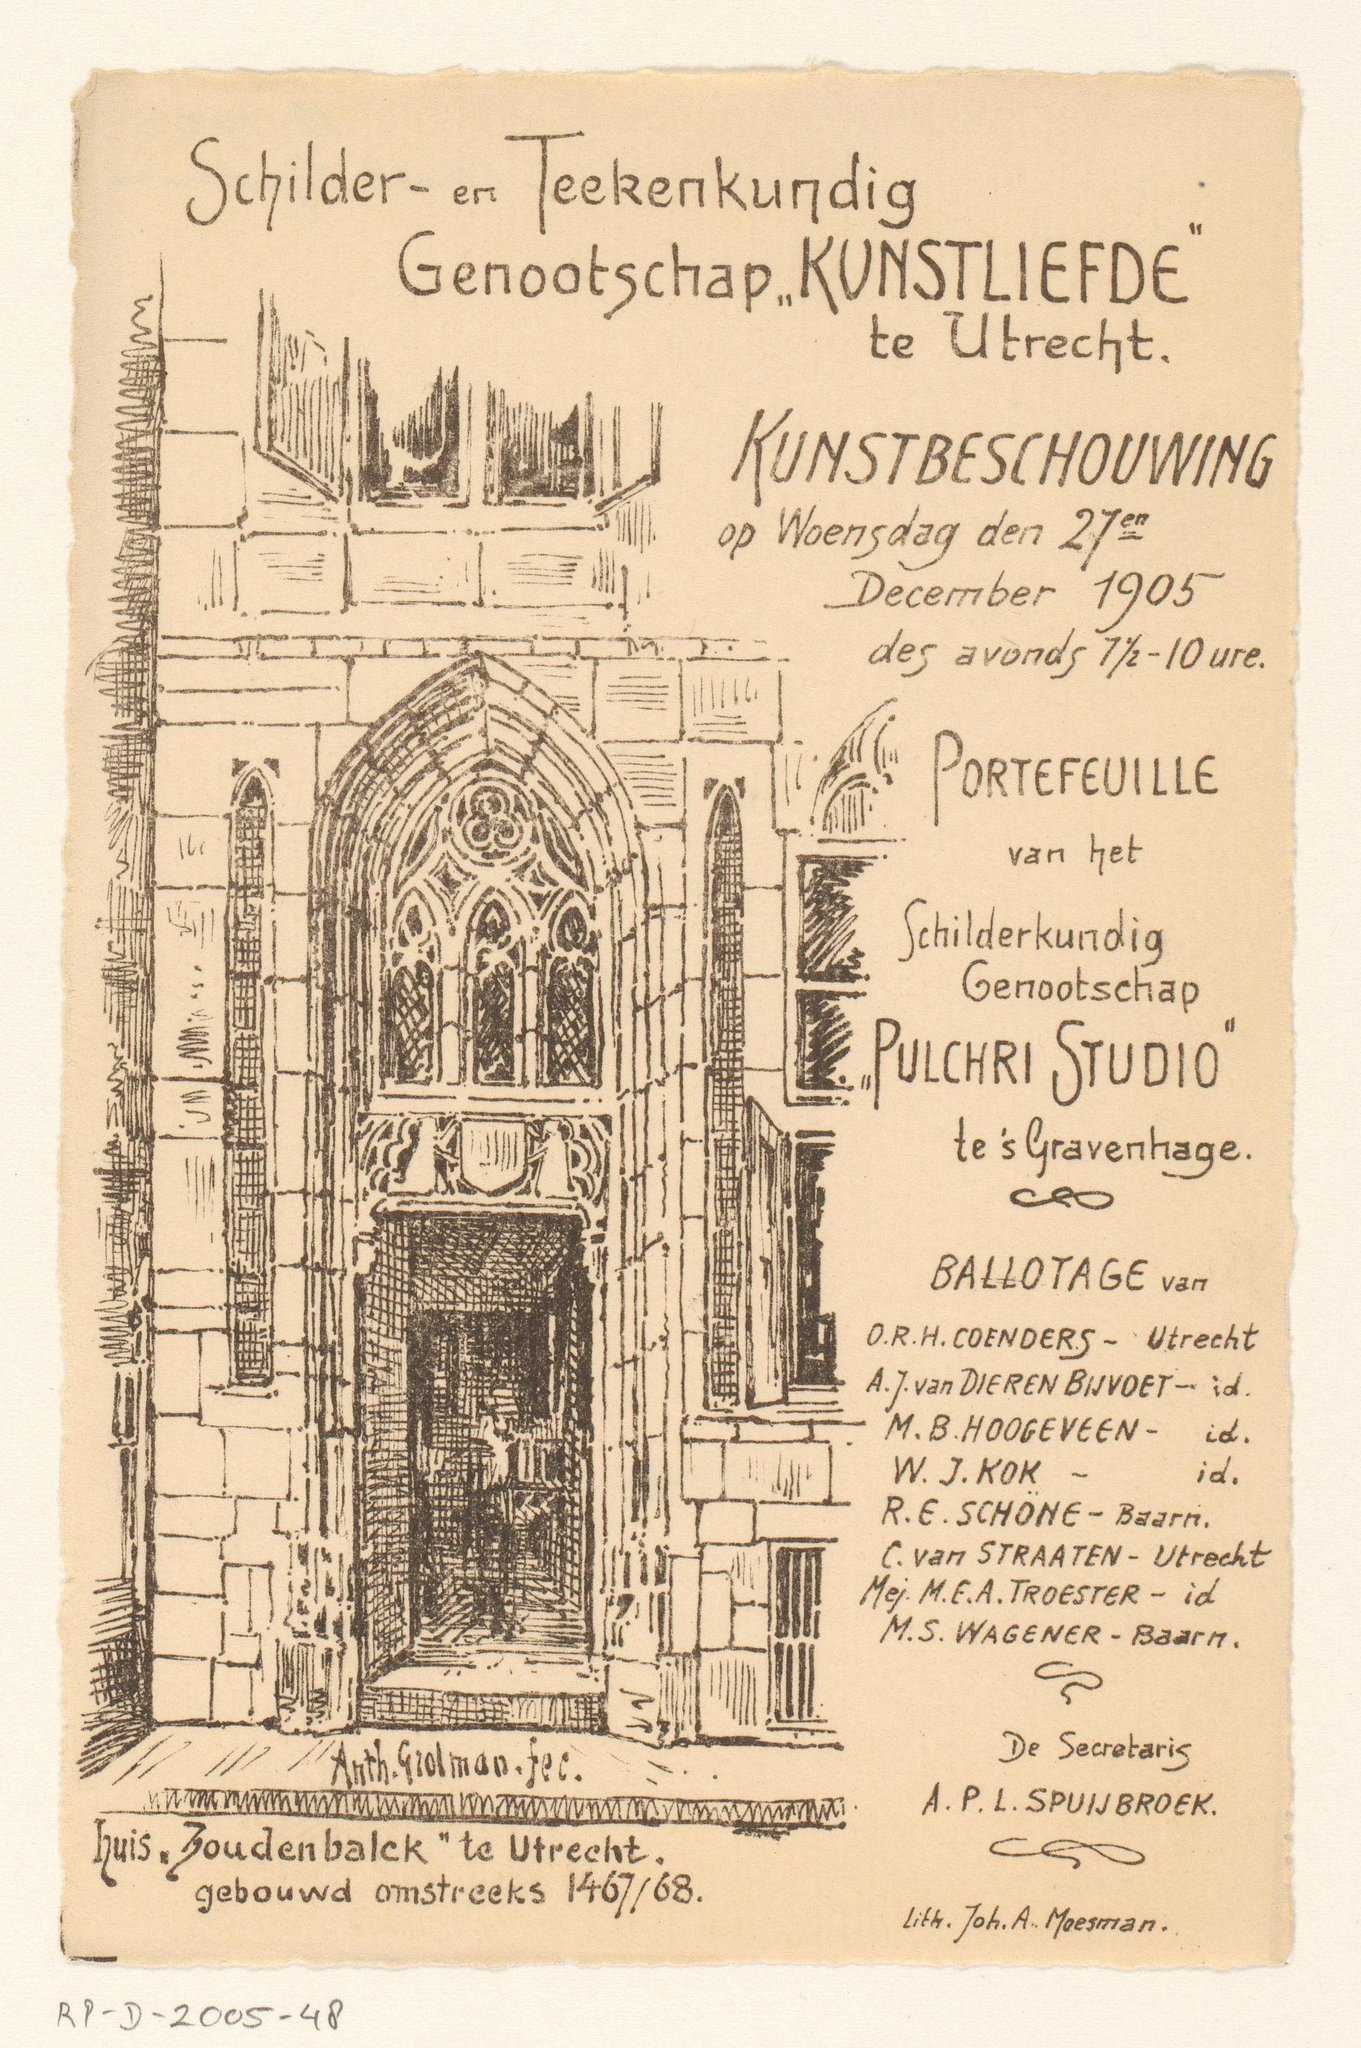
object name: invitation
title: Uitnodiging van Schilder- en Teekenkundig Genootschap "Kunstliefde" voor een kunstbeschouwing, 27 december 1905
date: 1905-1912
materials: paper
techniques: lithograph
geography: utrecht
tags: criticizing and discussing art, art criticism, circle, club of artists, collecting and exhibiting products of the fine arts, gate, entrance, door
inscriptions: collector's mark: Lugt 2228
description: Portaal van Huis Zoudenbalch te Utrecht uit 1467-68. Uitnodiging van Schilder- en Teekenkundig Genootschap "Kunstliefde" voor een kunstbeschouwing op 27 december 1905 van de portefeuille van het Schilderkundig Genootschap "Pulchri Studio" te Den Haag.